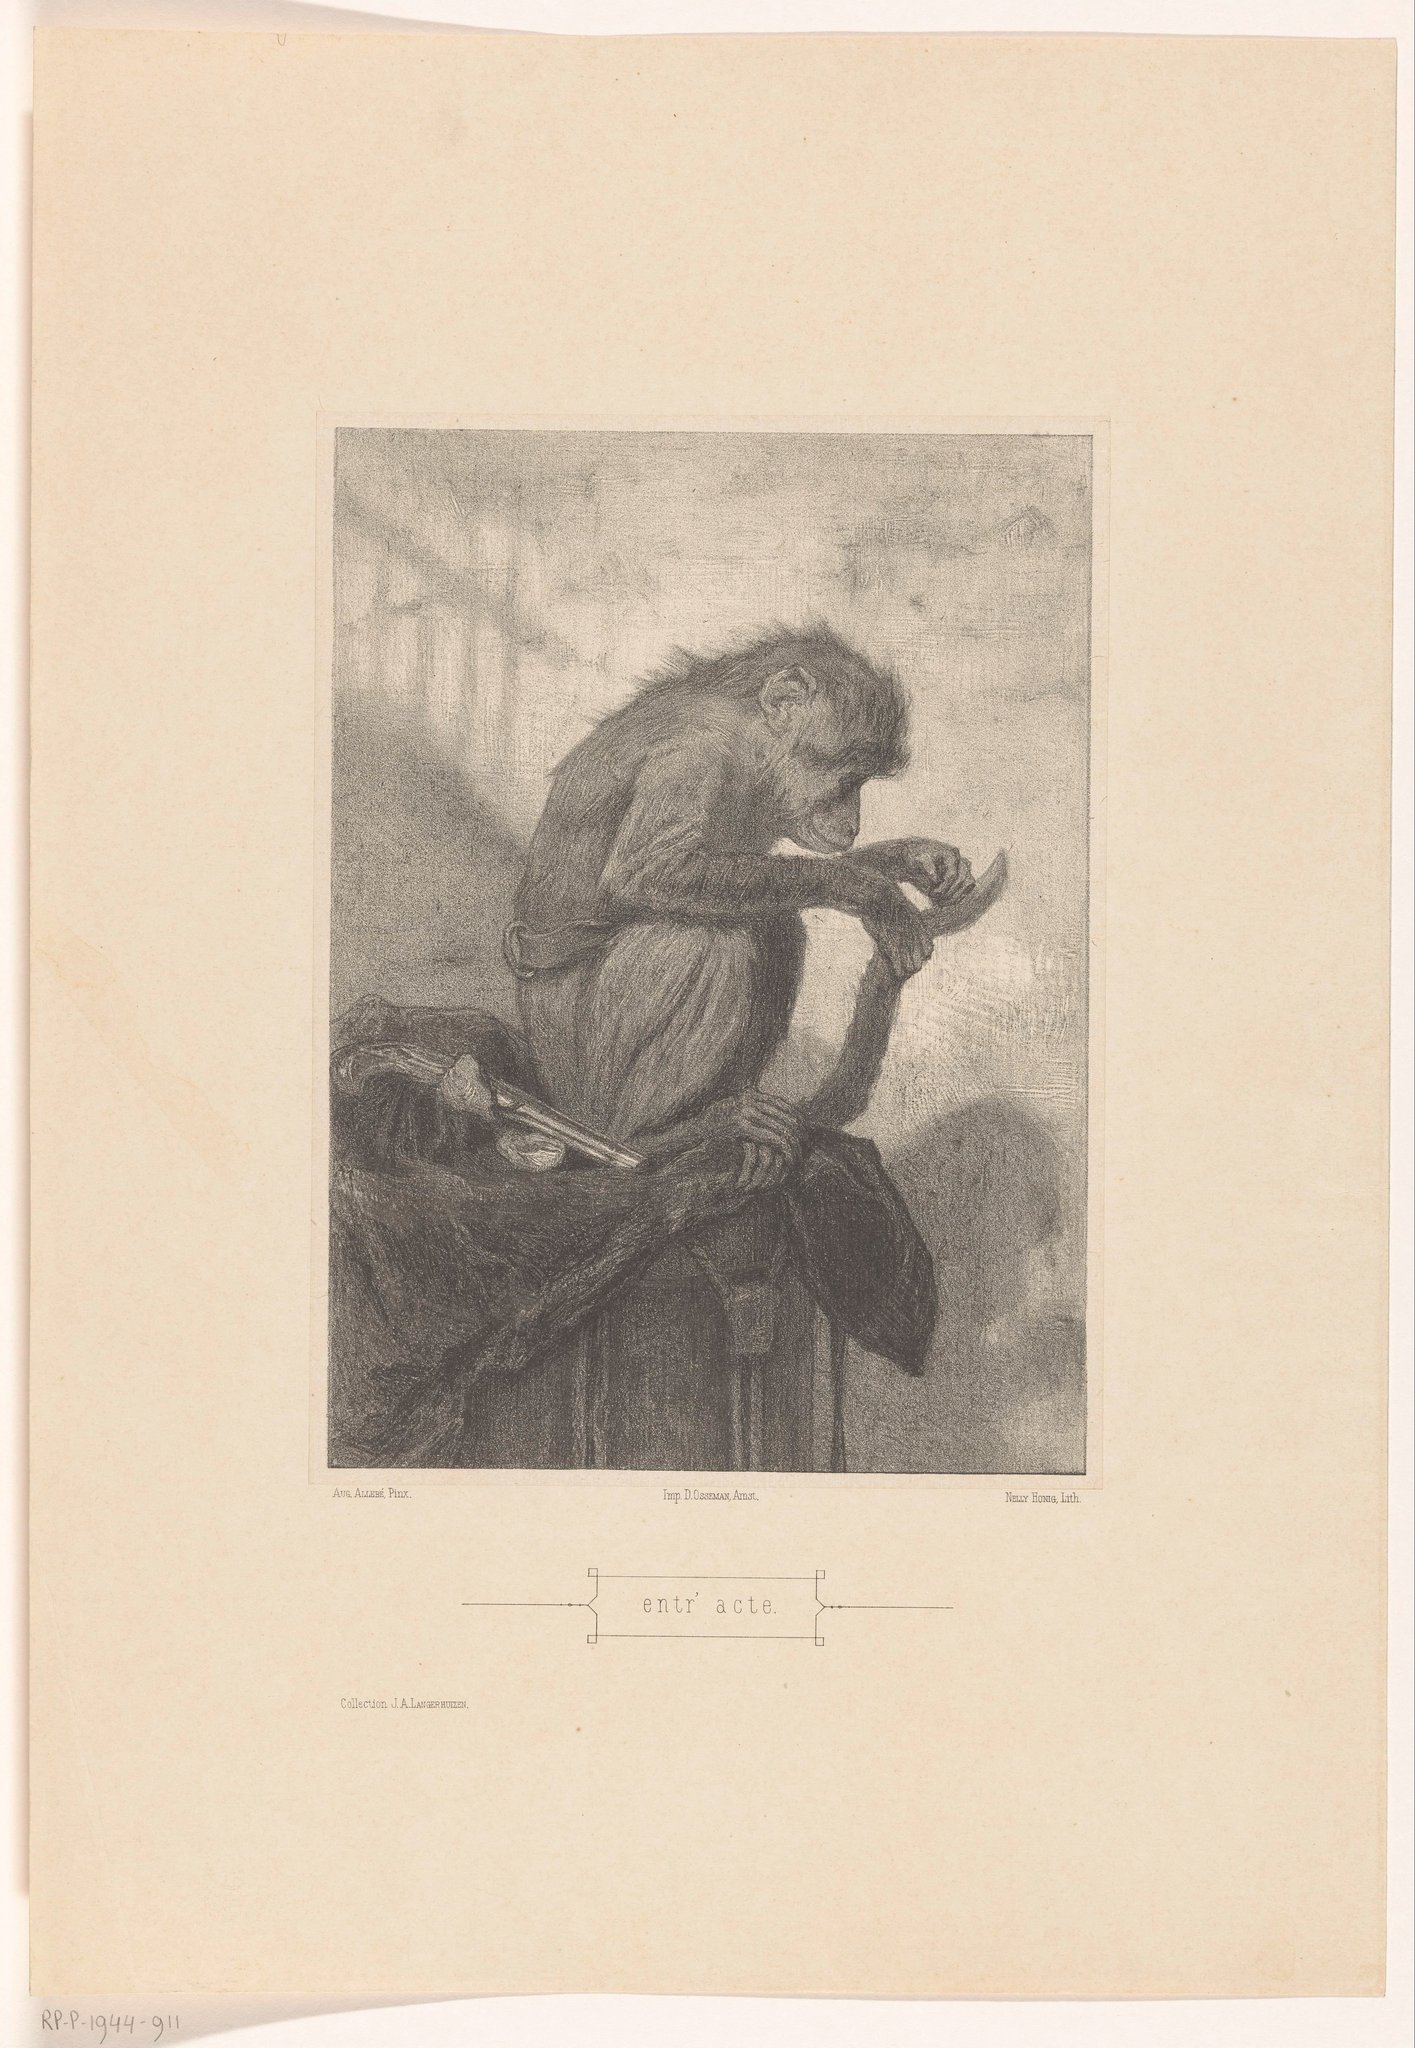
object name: print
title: Vlooiende aap met revolver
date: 1894-1944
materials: paper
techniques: letterpress printing, lithograph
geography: amsterdam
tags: monkeys, apes, looking for fleas, firearms (with name)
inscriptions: collector's mark, collector's mark: Lugt 2228, : ‘Litho naar [...] v. Aug Allebé in bezit v. mevr. Weber. Litho v. N. Honig.’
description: Een aap met een riem om zijn middel zit zijn staart te vlooien. Naast hem ligt een revolver. Op de wand achter hem de schaduw van tralies.